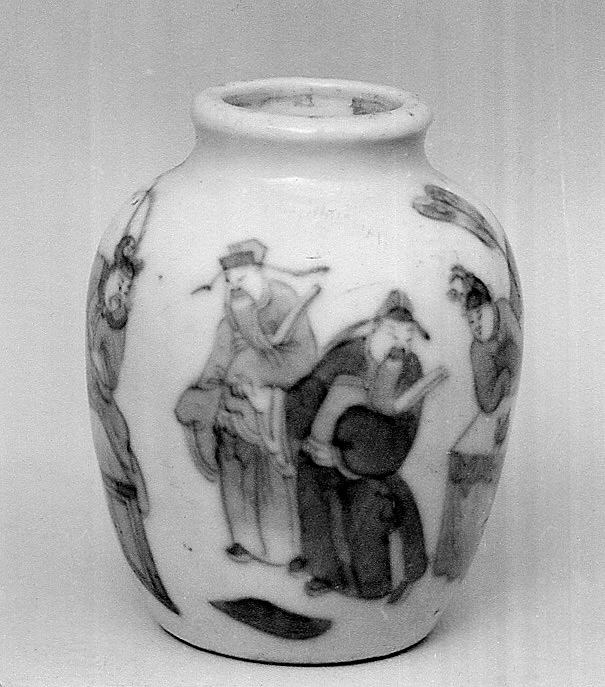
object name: snuff bottle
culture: chinese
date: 1736-1795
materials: porcelain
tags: men